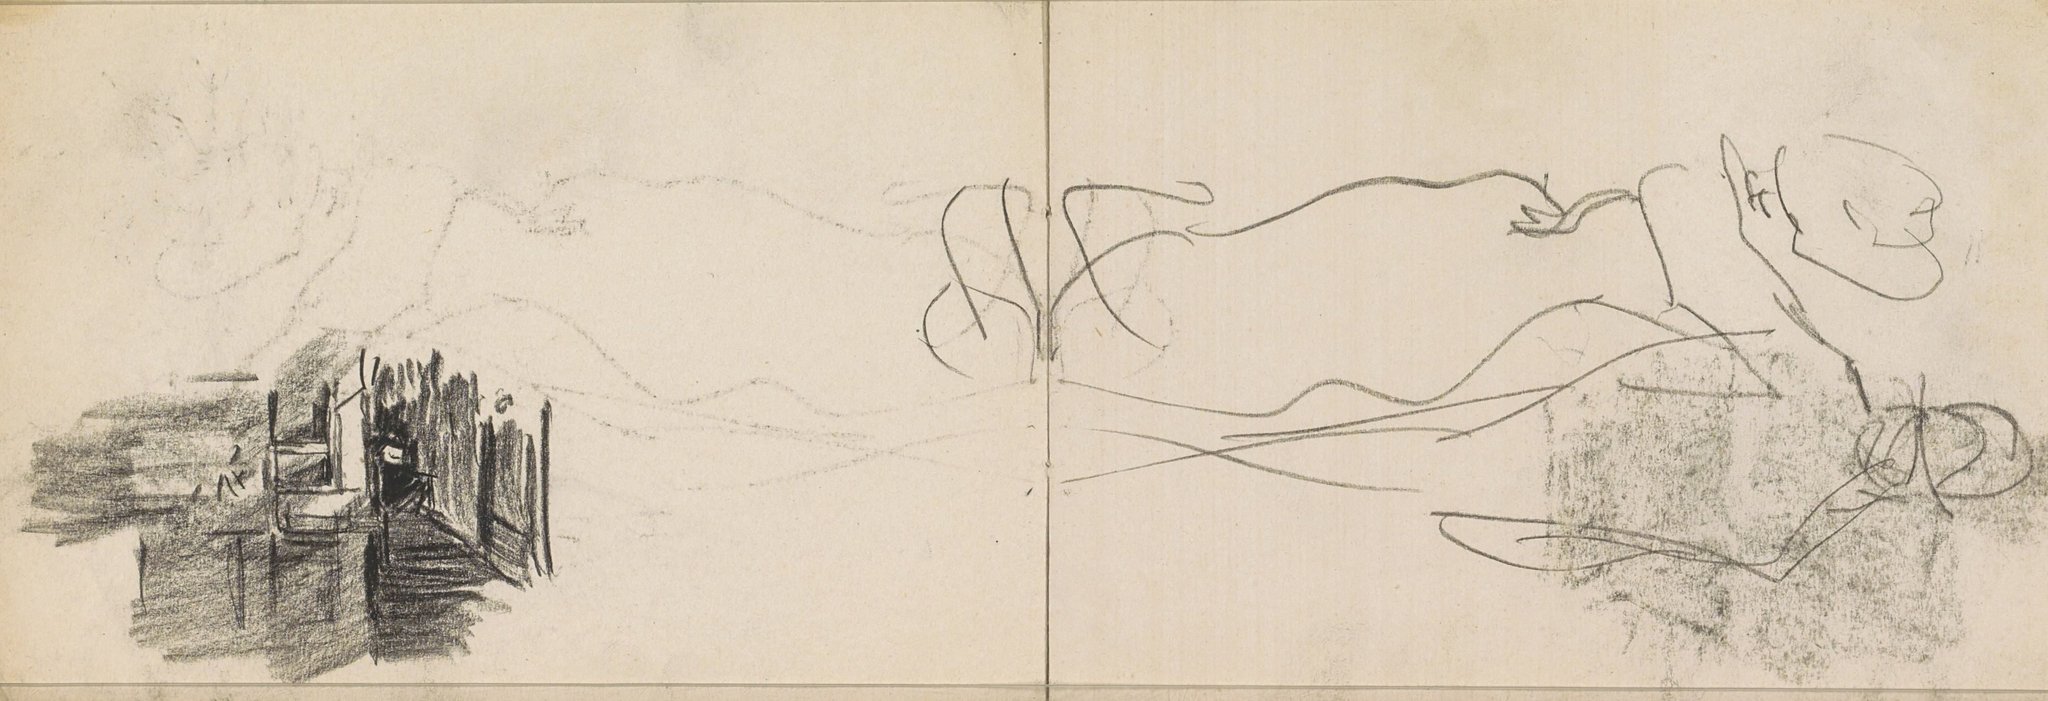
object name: sketchbook leaf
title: Interieur en een staand paar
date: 1875-1934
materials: chalk, paper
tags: adult woman (+ standing), interior of the house, adult man (+ standing)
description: Pagina 8 en pagina 9 uit schetsboek XLVI met 32 pagina's.